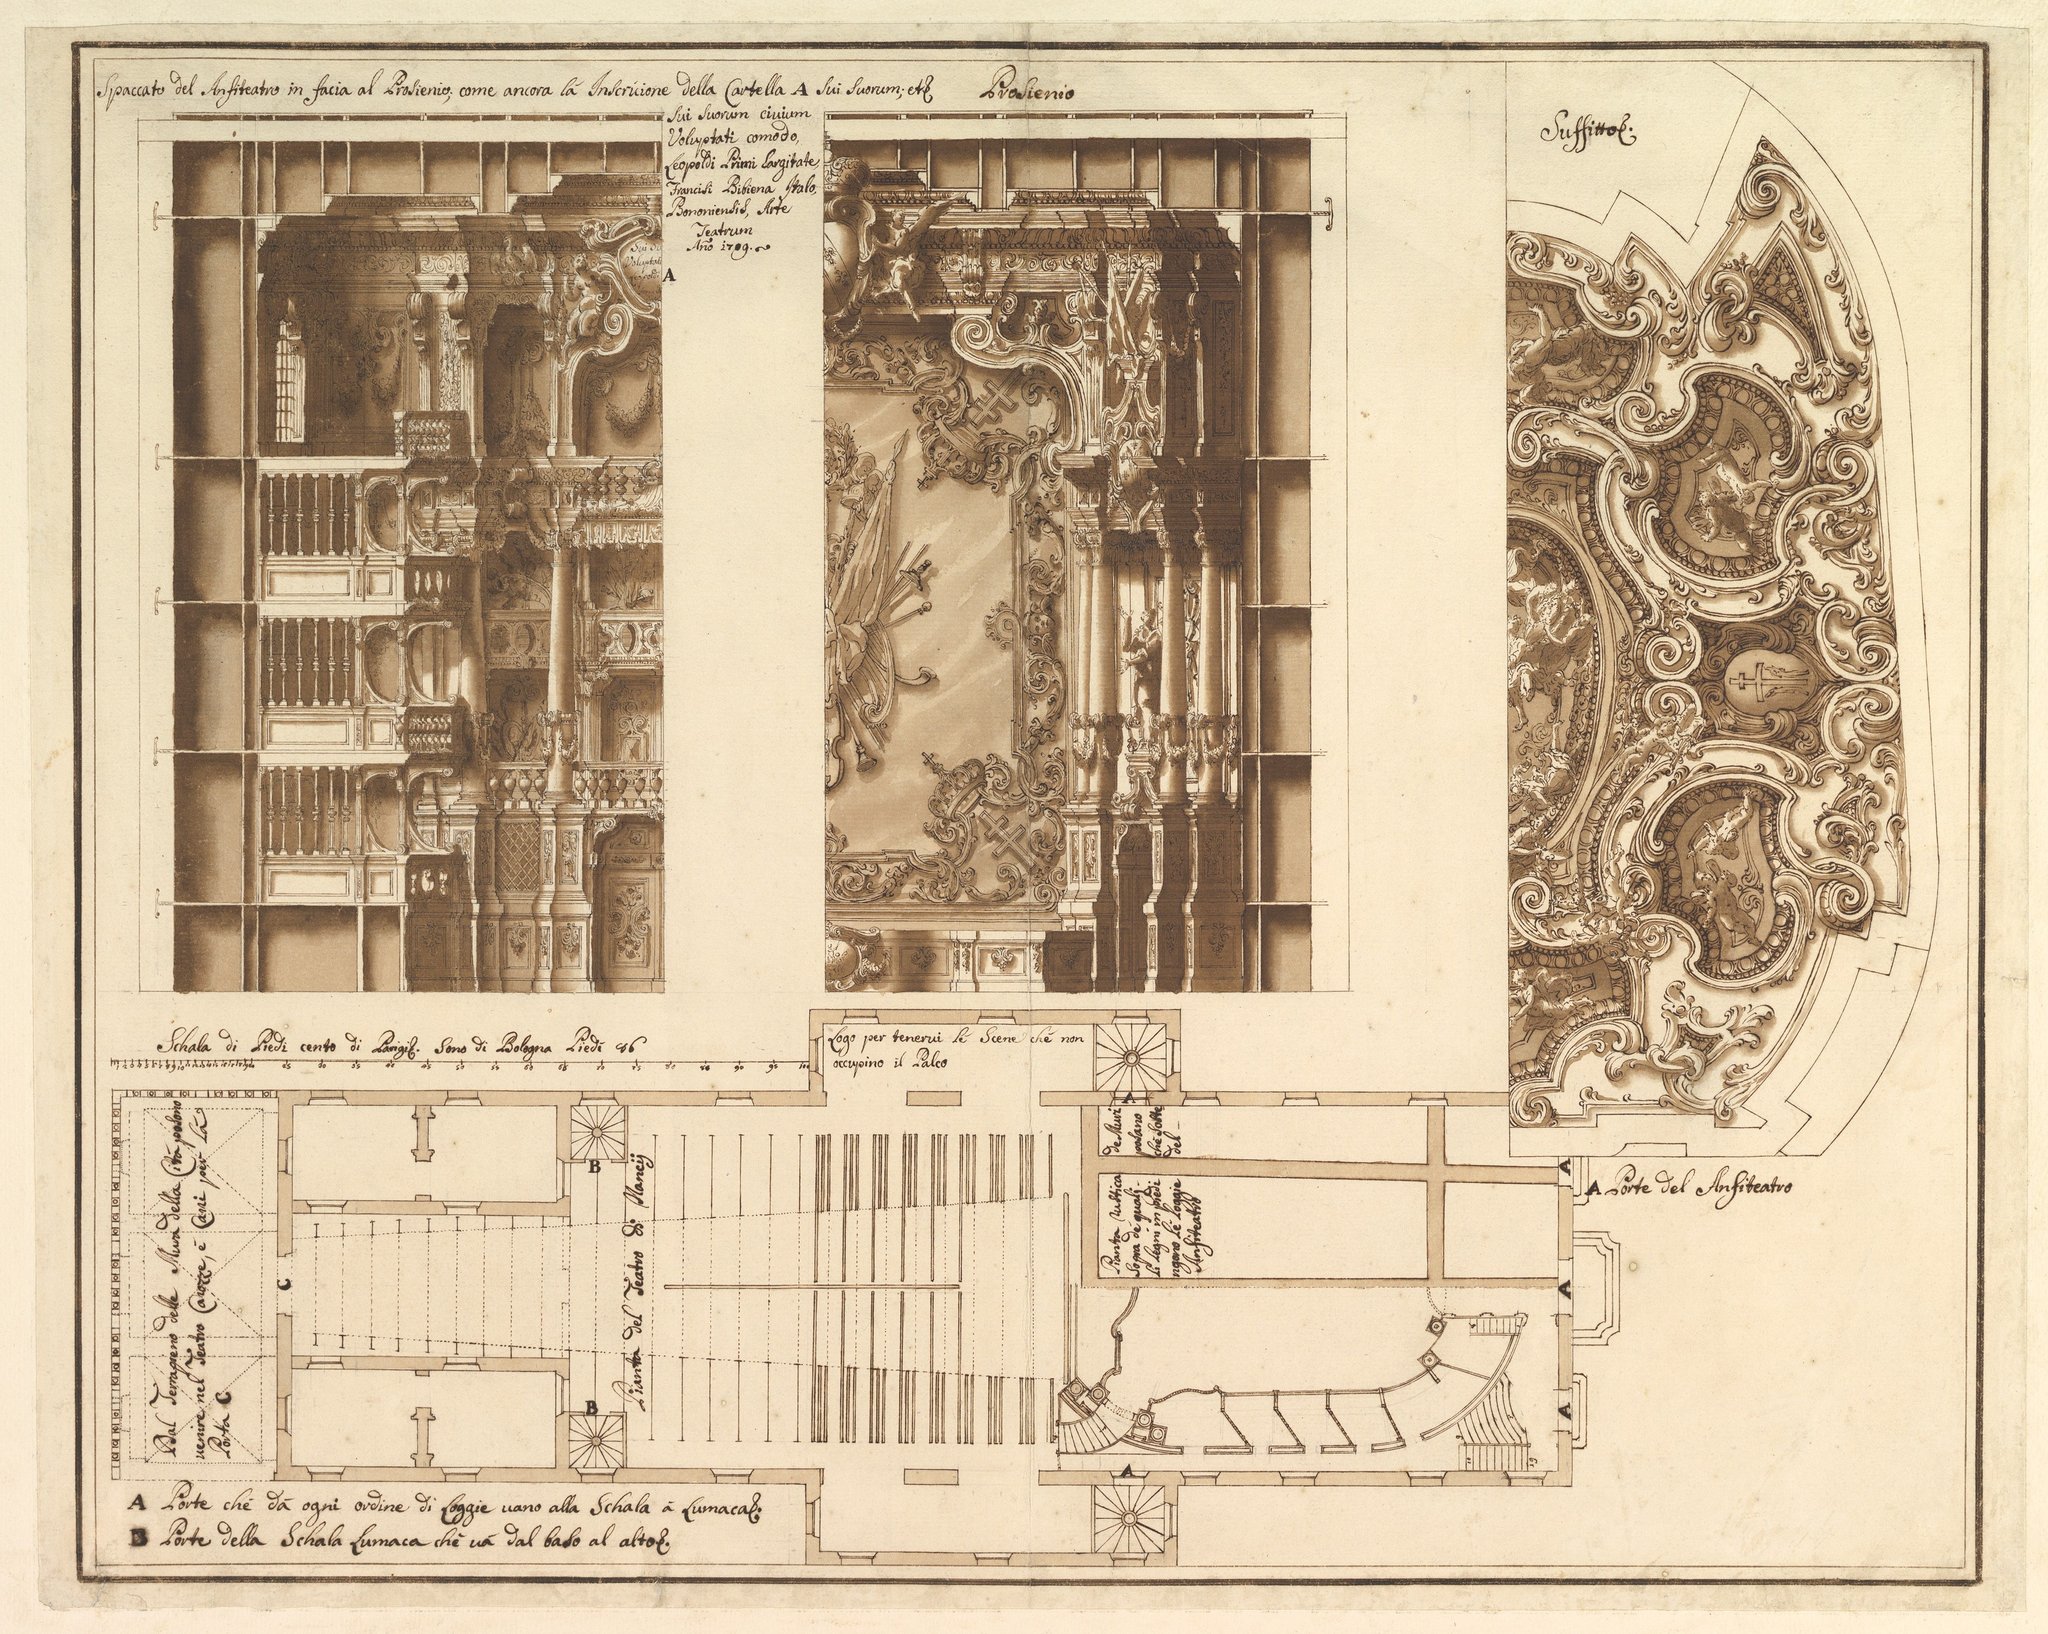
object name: drawing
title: Designs for the Theater at Nancy: View of Half the Proscenium and a Half a Section of It; End of the Ceiling; and Ground Plan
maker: francesco galli bibiena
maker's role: artist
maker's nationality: italian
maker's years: 1659-1739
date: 1659-1739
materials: ink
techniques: brush, pen, wash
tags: theatre,architecture